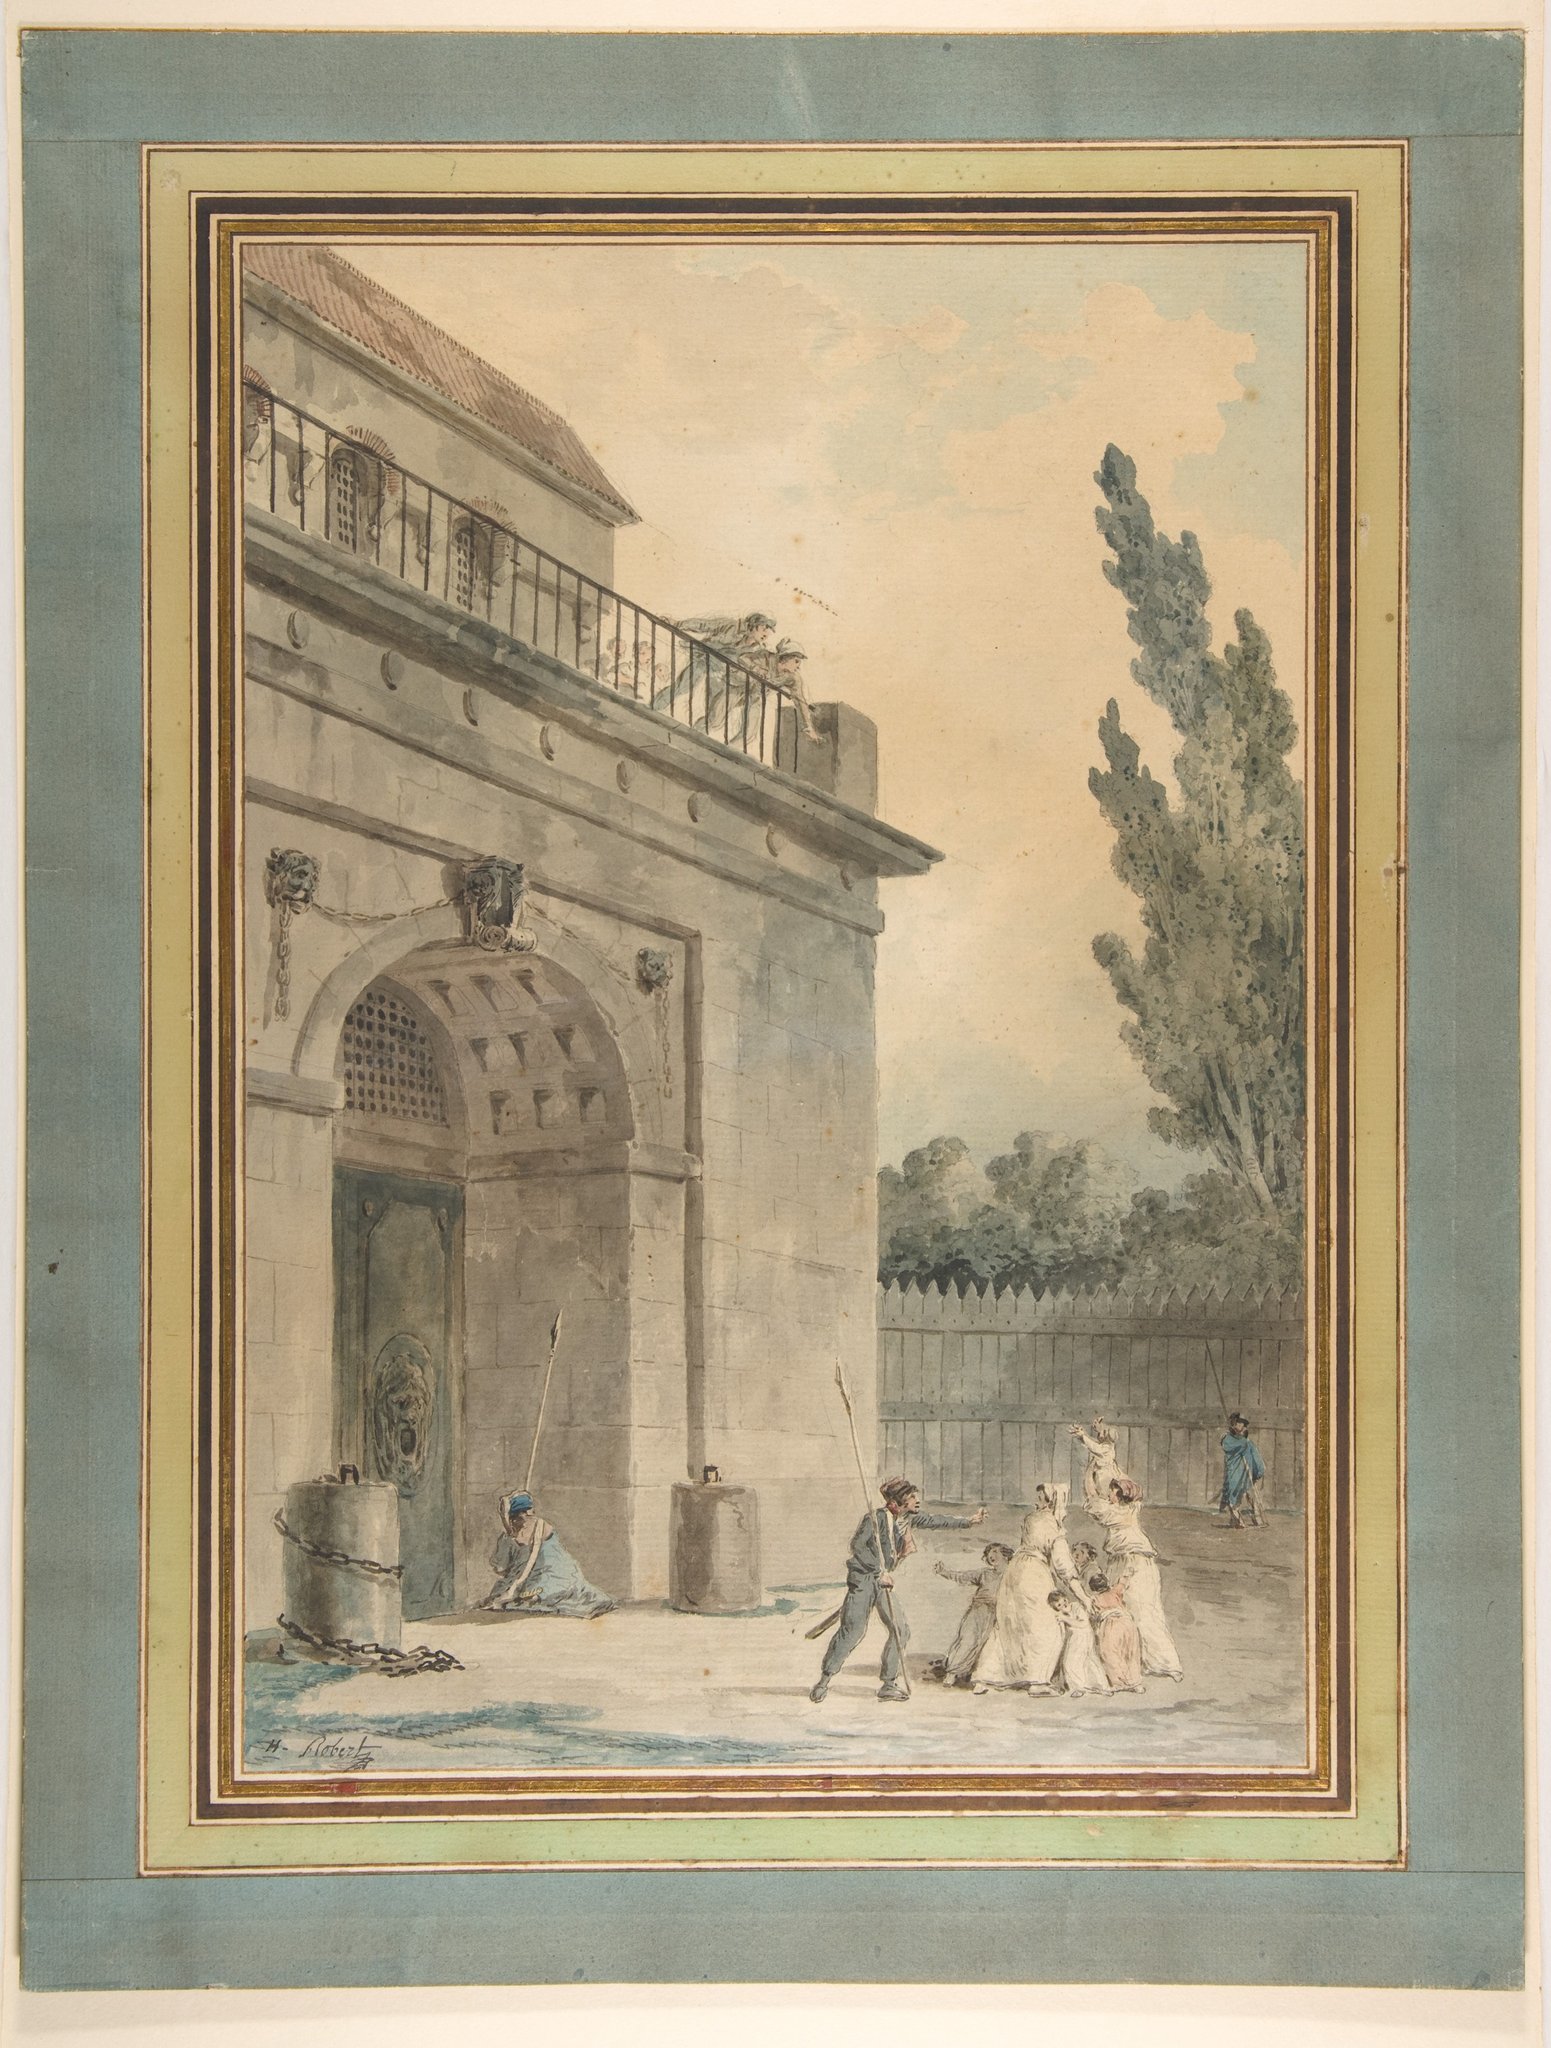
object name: drawing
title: Visitors leaving a prison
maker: hubert robert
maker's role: artist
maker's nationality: french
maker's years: 1733-1808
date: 1794-1795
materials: chalk, ink, watercolor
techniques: brush, pen, drawing, wash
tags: prisons,children,men,women